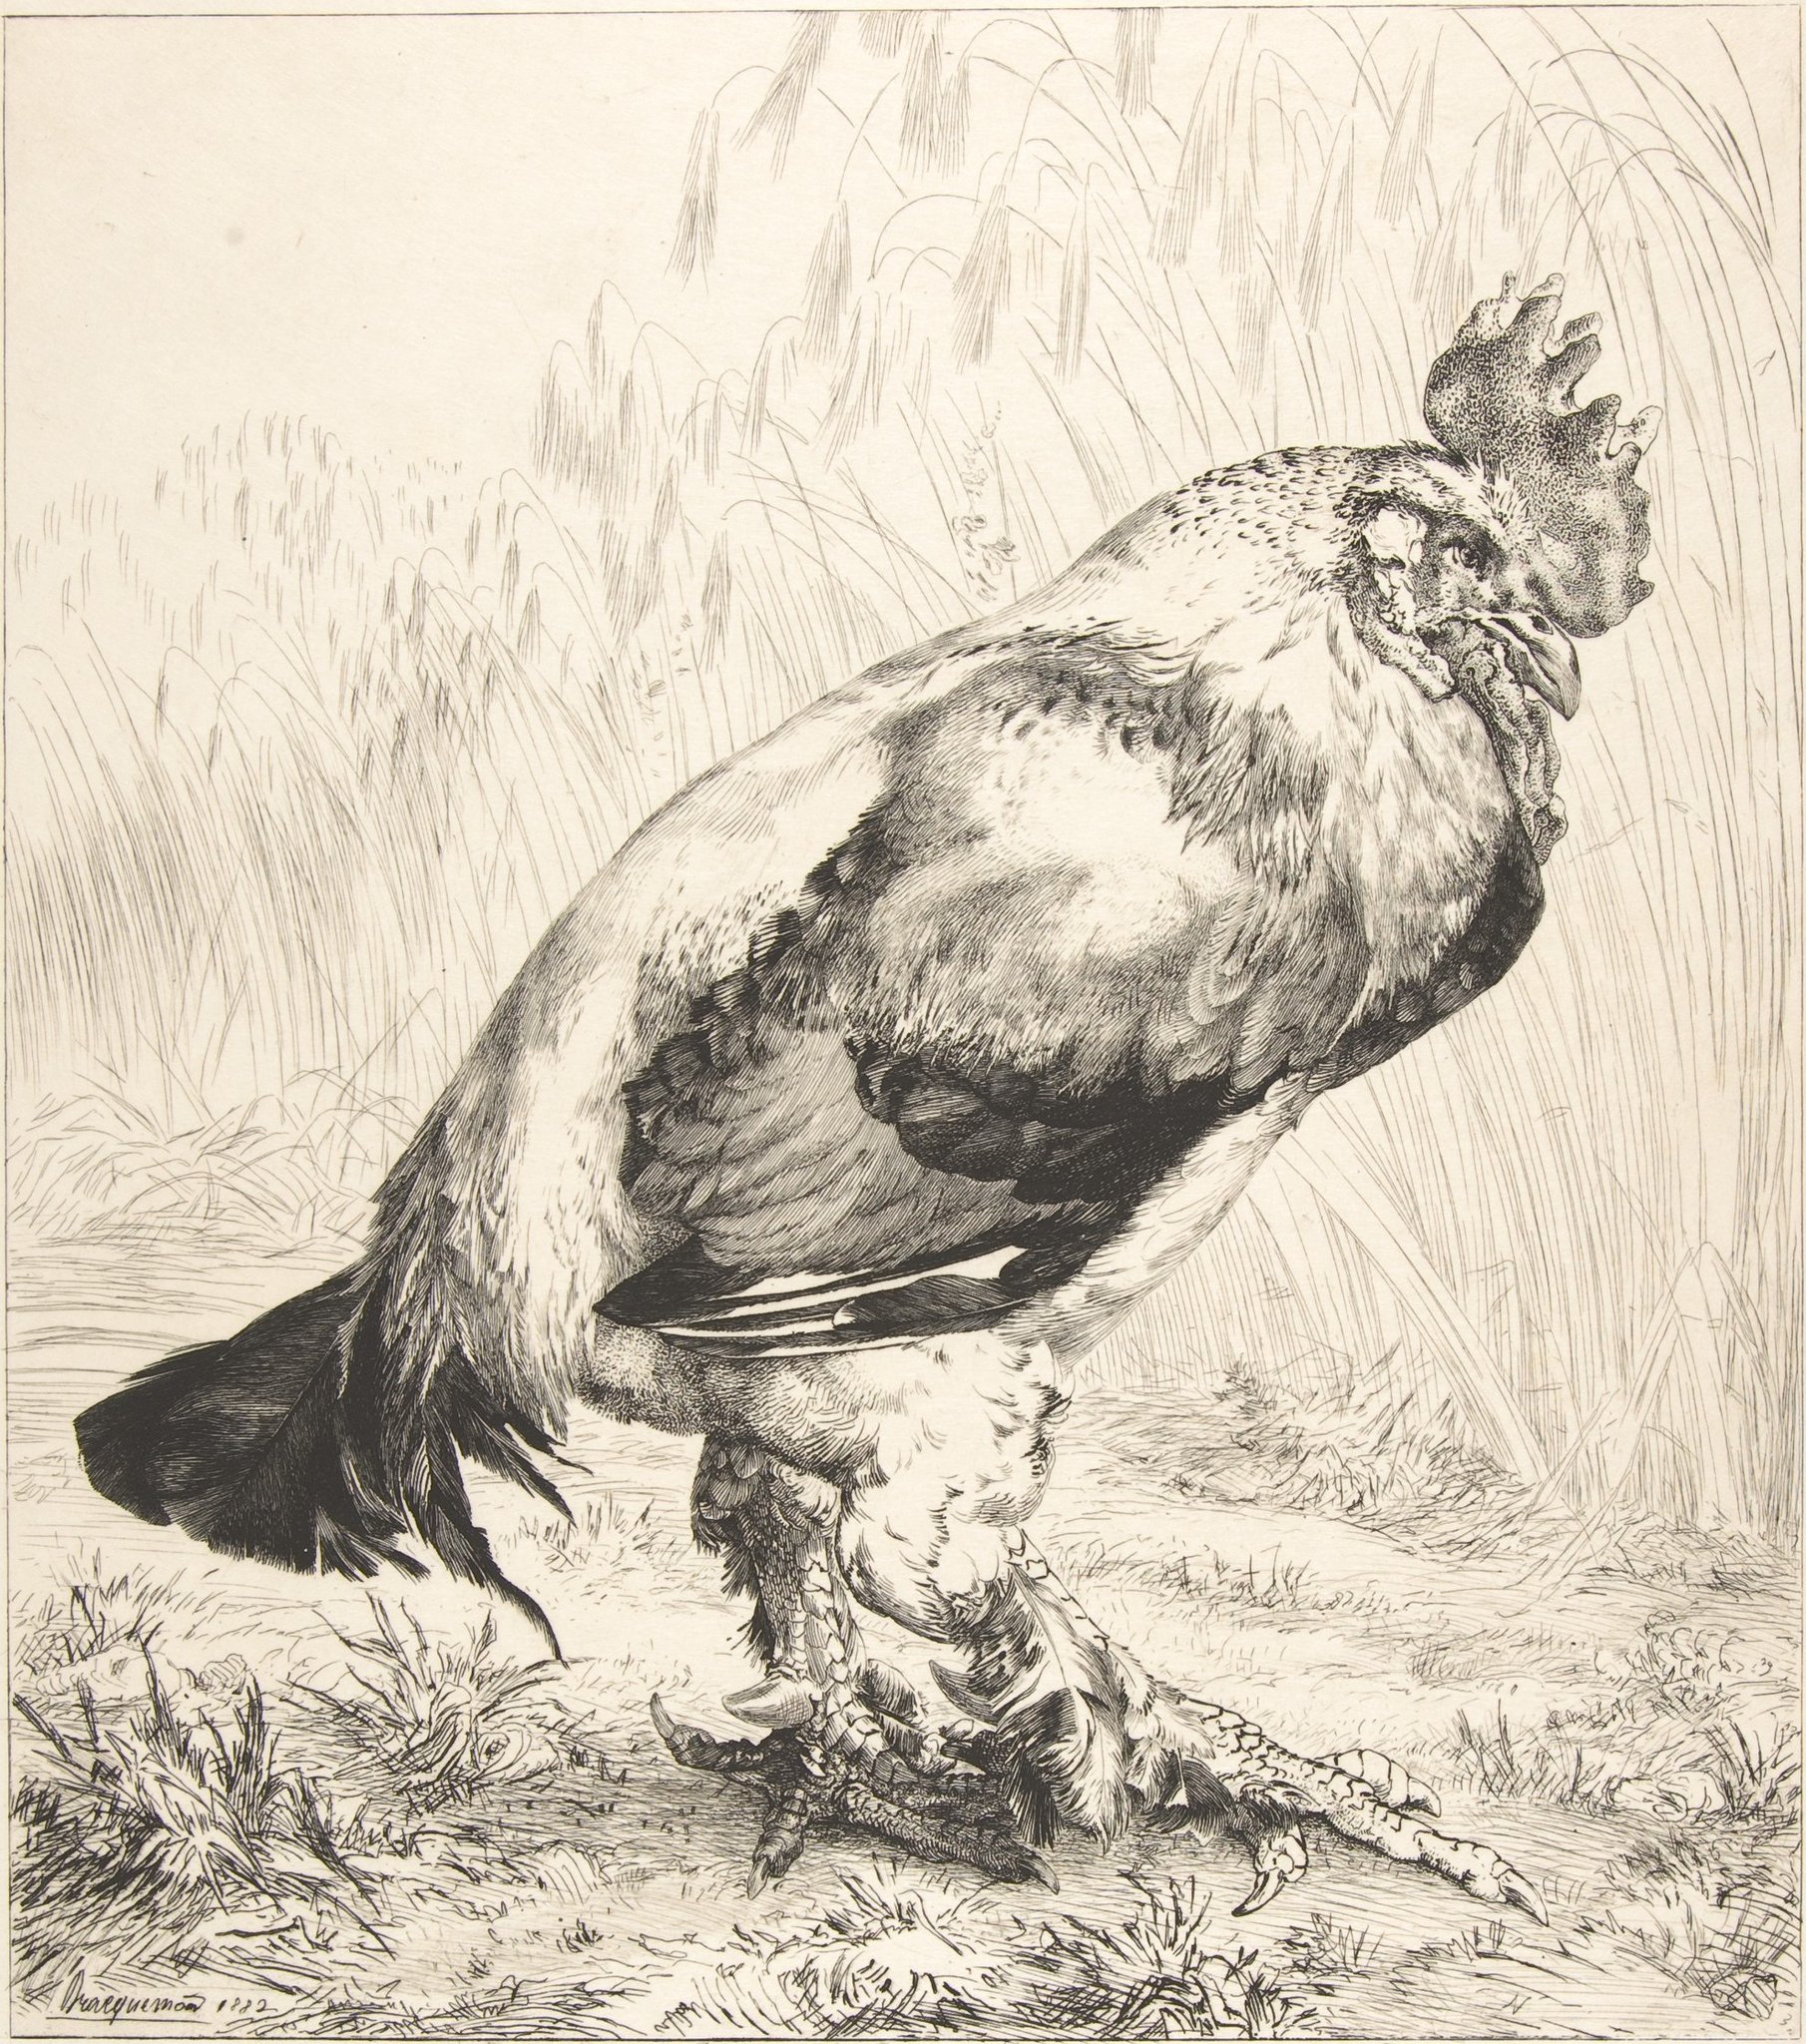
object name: print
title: The Old Cock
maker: félix bracquemond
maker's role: artist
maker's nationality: french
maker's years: 1833-1914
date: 1882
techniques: etching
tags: roosters